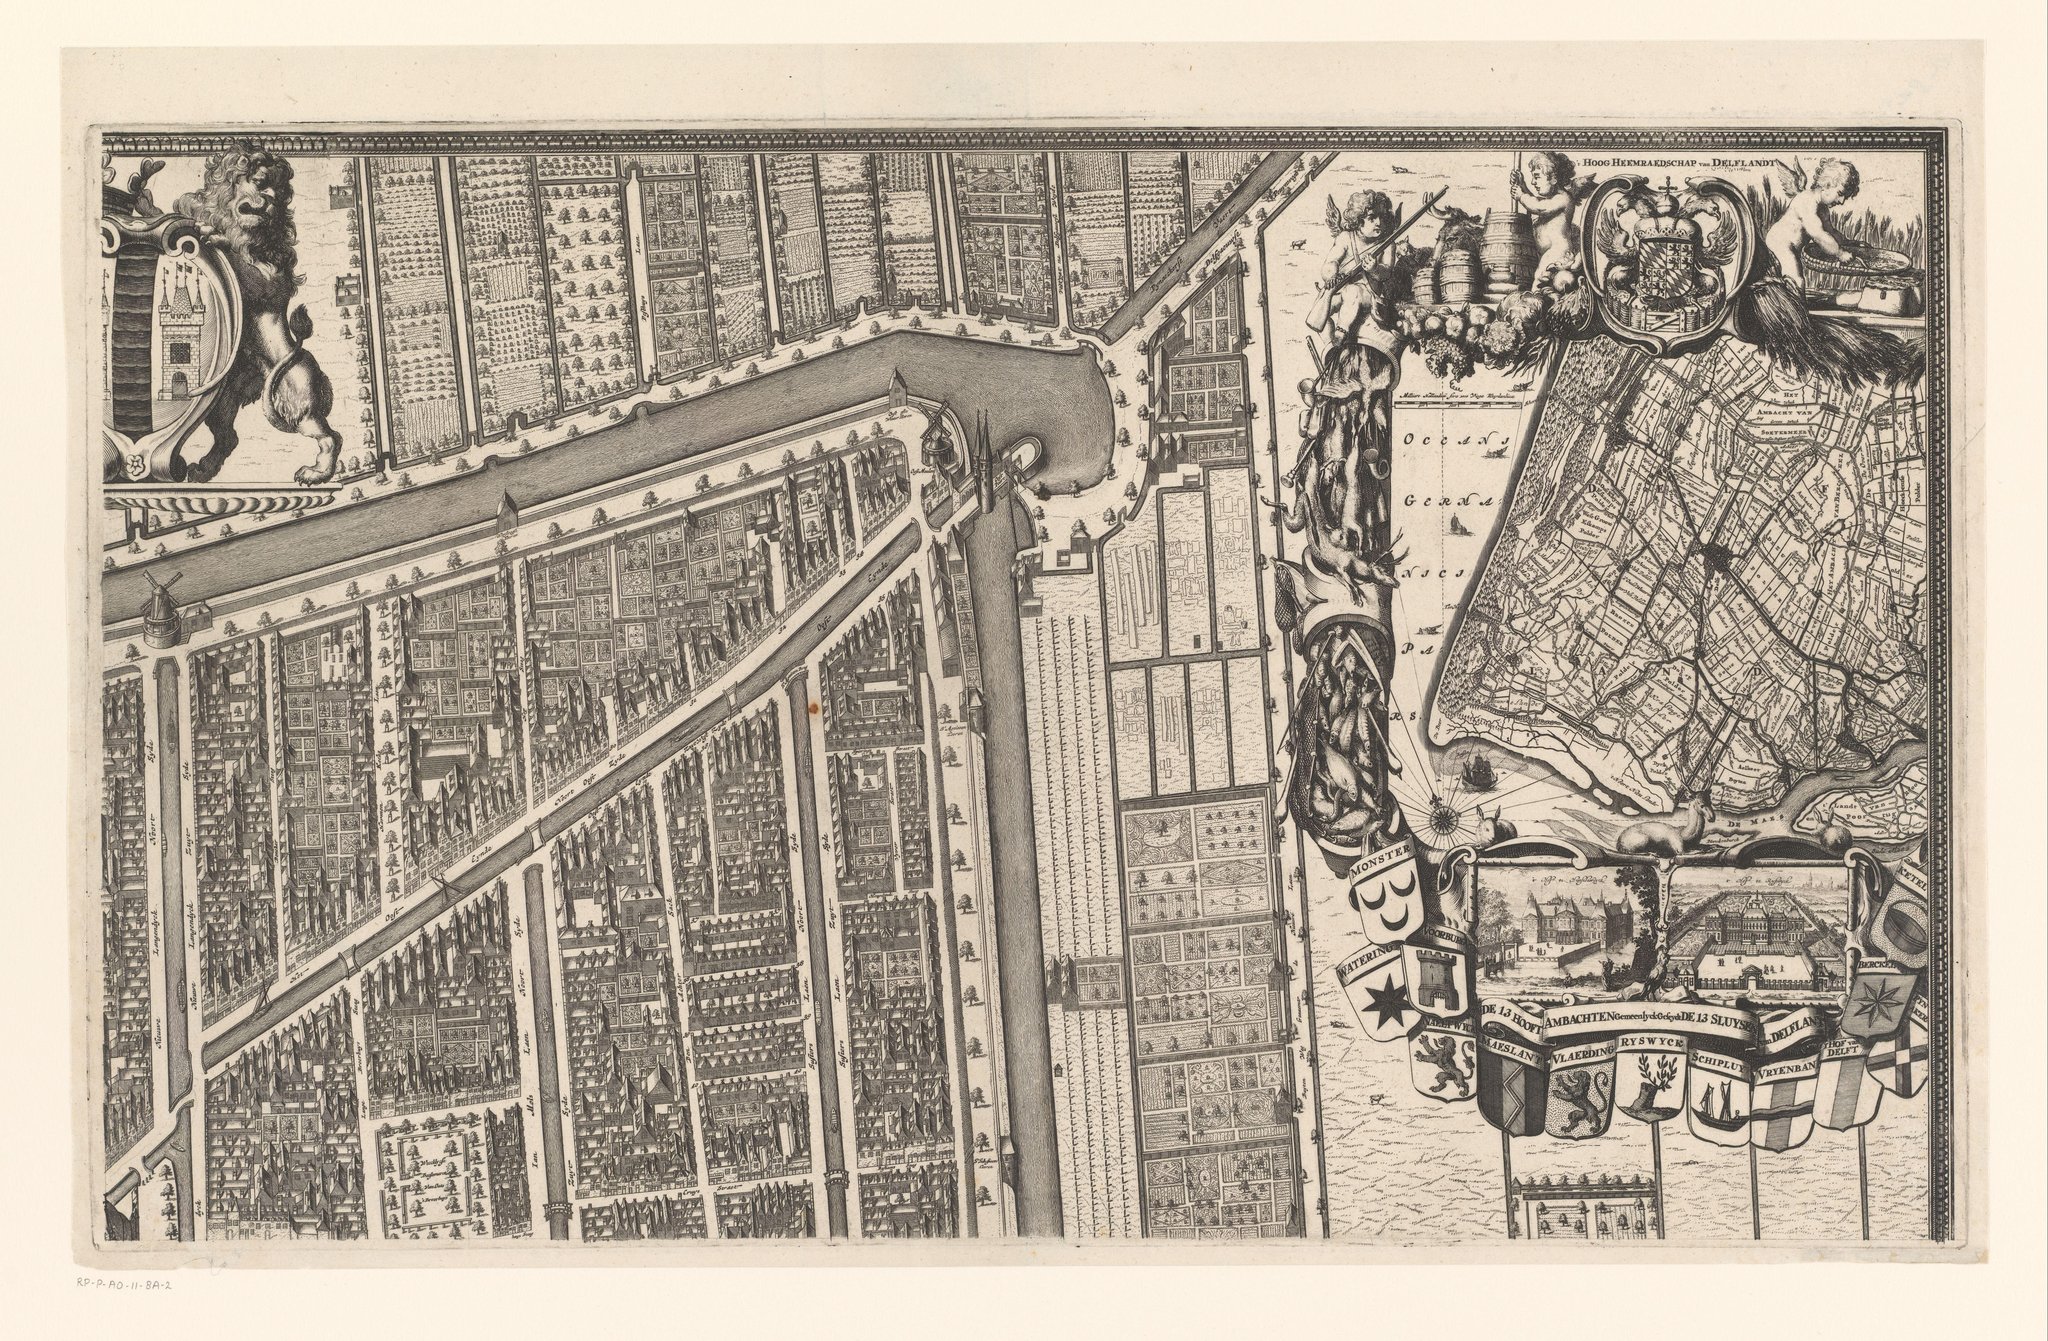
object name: area plan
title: Plattegrond van de Kaart Figuratief van Delft (deel rechtsboven)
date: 1678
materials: paper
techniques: engraving, etching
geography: delft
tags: commercial fishery, coat of arms (as symbol of the state, etc.) (+ city; municipal), maps of separate countries or regions, hunting, chase, agriculture, maps of cities, delft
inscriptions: collector's mark: Lugt 2228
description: Deze prent is onderdeel van de tweede staat* van de plattegrond van de zogenaamde Kaart Figuratief (Caerte figuratyff / Kaerte figuratyf) van Delft, een wandkaart van Delft die voor het eerst werd uitgegeven in 1678. Deze kaart bestaat uit een plattegrond van Delft (RP-P-AO-11-8A) met daaromheen een rand. De rand bestaat uit een profiel van Delft (RP-P-AO-11-11), een profiel van Delfshaven met daaronder de wapenschilden van de burgemeesters van de stad (RP-P-AO-13-51-1 en RP-P-AO-13-51-2), 24 kleinere prenten (kaarten, afbeeldingen van gebouwen en graven van bekende personen, o.a. RP-P-AO-11-15, RP-P-AO-11-16, RP-P-AO-11-17, RP-P-AO-11-18, RP-P-AO-11-19, RP-P-AO-11-20, RP-P-AO-11-21, RP-P-AO-11-23, RP-P-AO-11-24, RP-P-AO-11-27, RP-P-AO-11-28, RP-P-AO-11-29, RP-P-AO-11-30, RP-P-AO-11-31, RP-P-AO-11-33C, RP-P-AO-11-34, RP-P-AO-11-35, RP-P-AO-11-35-2, RP-P-AO-13-49, RP-P-AO-13-52, RP-P-AO-13-53, RP-P-AO-13-54-1 en RP-P-1909-6463) en een beschrijving van de stad (RP-P-AO-11-8E). In 1678 werd de kaart, in opdracht van het Delftse stadsbestuur, voor het eerst in zijn geheel uitgegeven door Pieter Smith. Pieter Mortier (I) verzorgde in 1703, tevens in opdracht van het stadsbestuur, een tweede uitgave. Voor deze druk bracht graveur Thomas van der Wilt enkele aanpassingen aan op de platen van de plattegrond. De randplaten lijken ongewijzigd te zijn gebleven, hoewel de plaat met de wapens van de burgemeesters werd vervangen door een nieuwe plaat met wapens van de toen zittende burgemeesters. Van de plattegrond zijn dus twee staten bekend. De tweede staat van de plattegrond is in 1752, waarschijnlijk zonder de randprenten, opnieuw uitgegeven. Het is onbekend wie deze druk heeft verzorgd. De kaart kon op verschillende manieren gemonteerd worden. Voor zowel de uitgave van 1678 als die van 1703 is een instructie bekend. Voor een exemplaar van de instructie uit 1703 zie RP-P-AO-11-93. Het is niet duidelijk of voor wat bekend staat als de tweede staat van deze plattegrond (1703) ook op de plaat van het huidige deel aanwijzingen zijn aangebracht. Wel is een stuk van een proefdruk bekend (RP-P-AO-11-94).